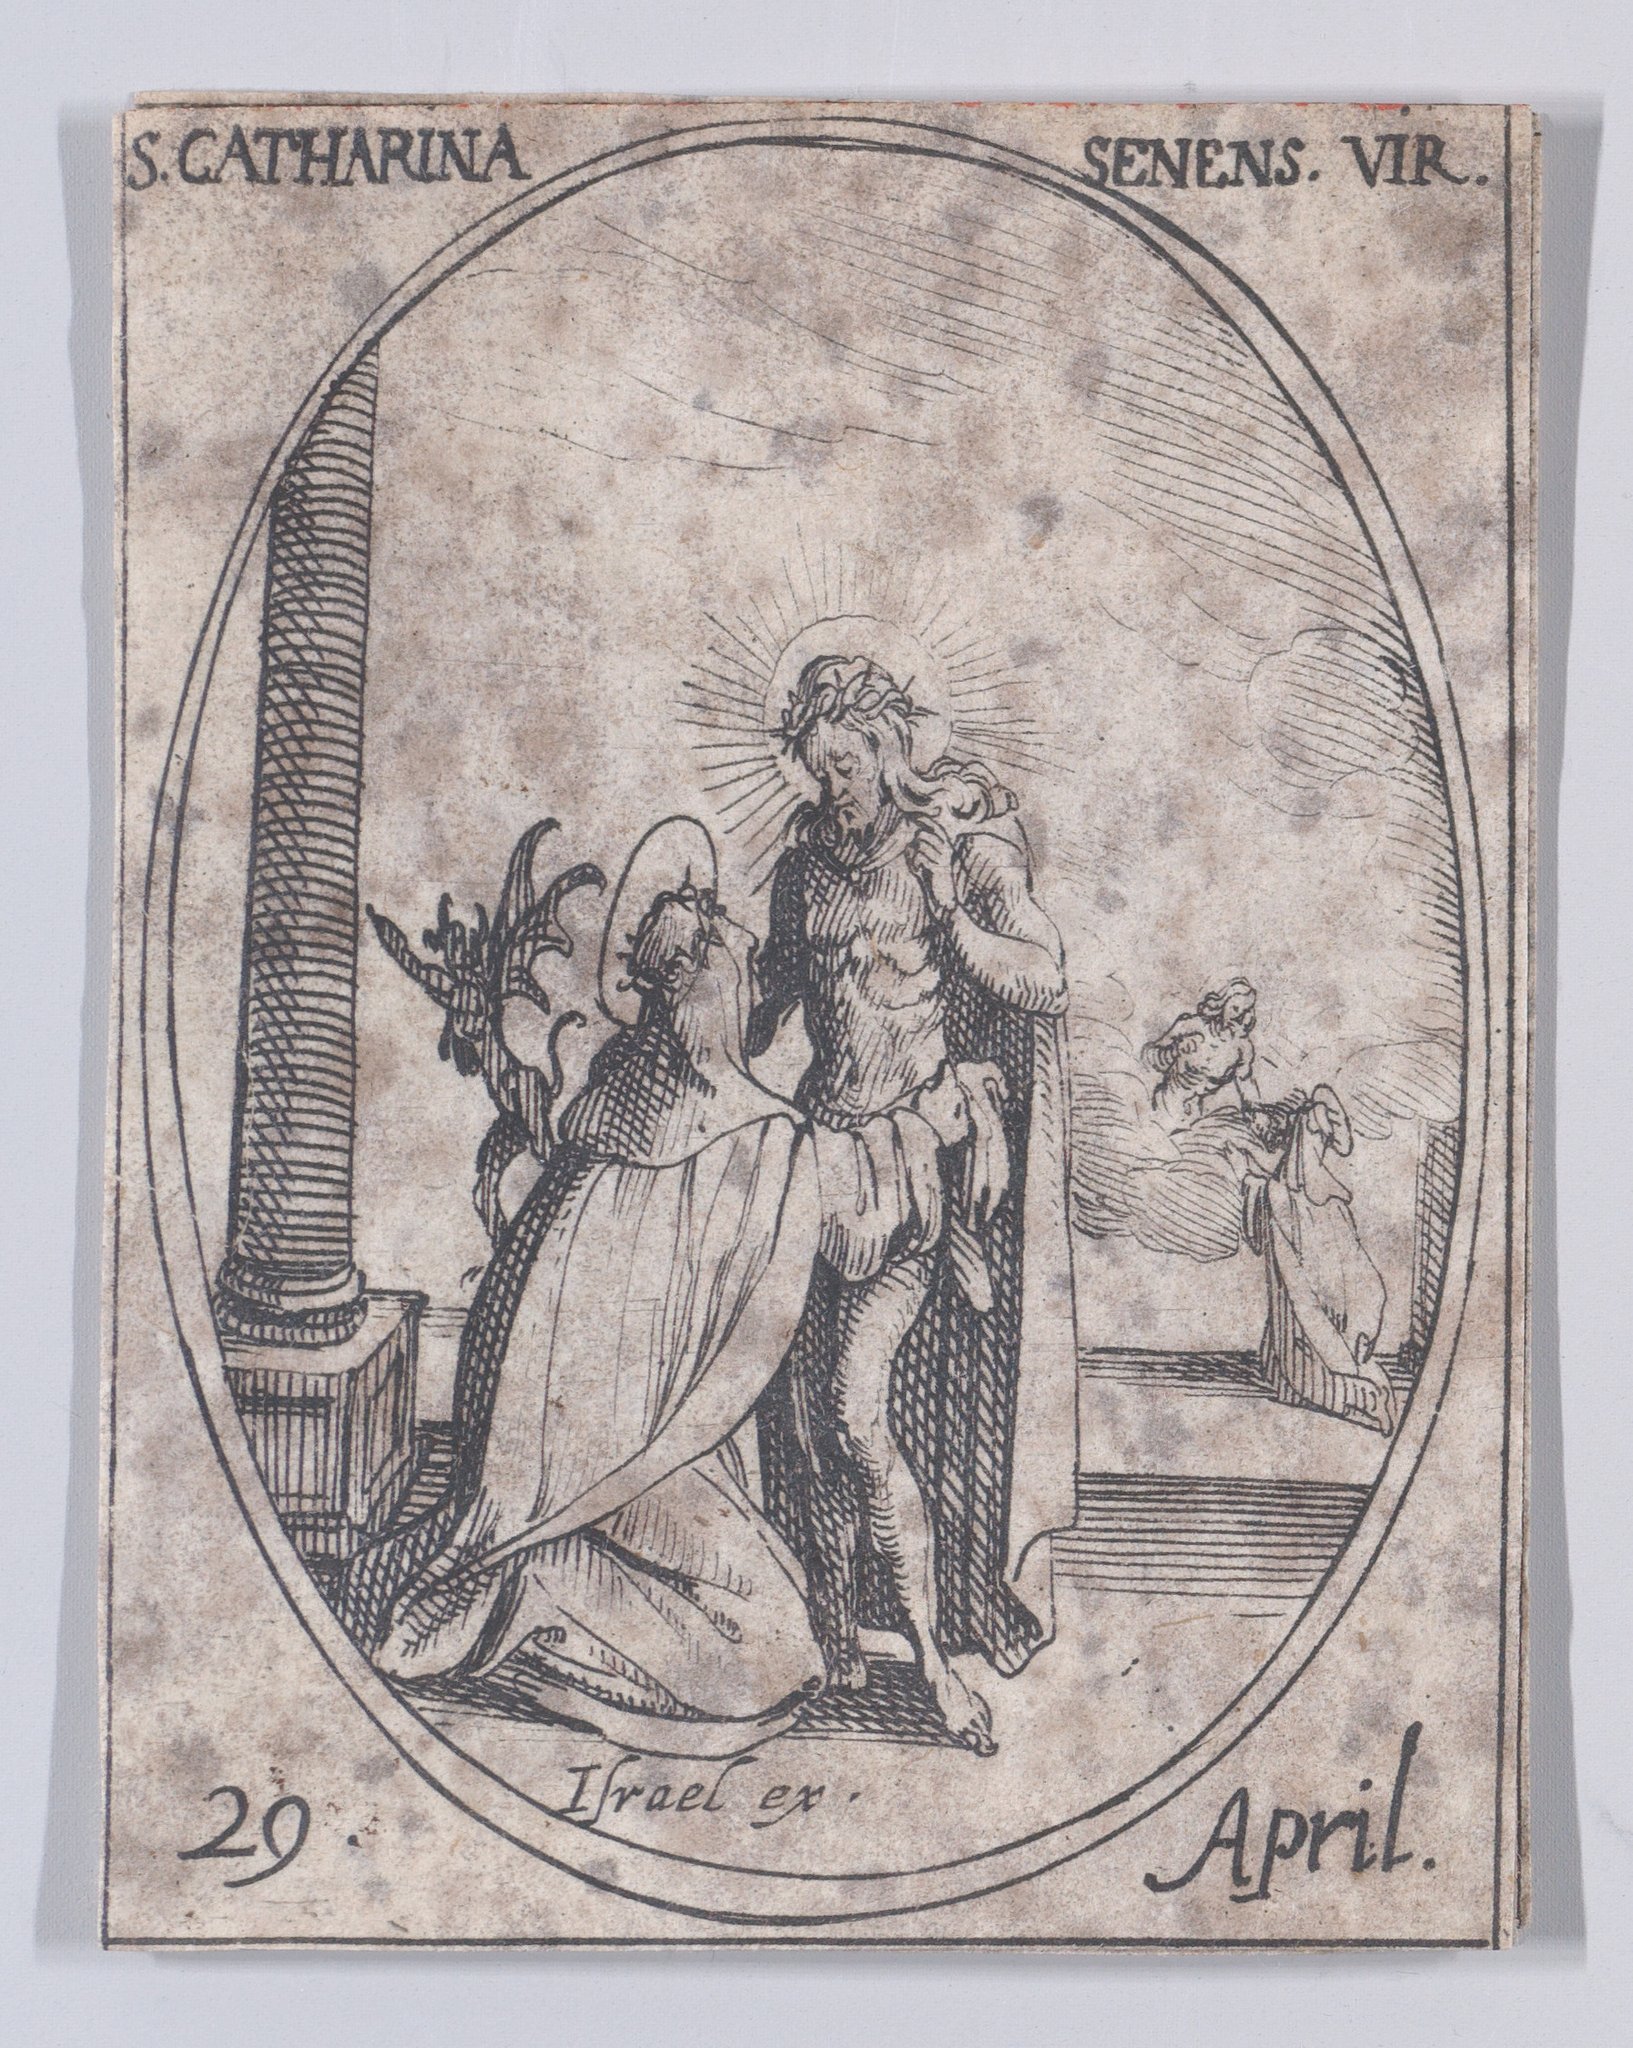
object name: print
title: Ste. Catherine de Sienne, vierge (St. Catherine of Siena, Virgin), April 29th, from "Les Images De Tous Les Saincts et Saintes de L'Année" (Images of All of the Saints and Religious Events of the Year)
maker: jacques callot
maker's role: artist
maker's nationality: french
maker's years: 1592-1635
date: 1636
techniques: etching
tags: men,women,christ,saints